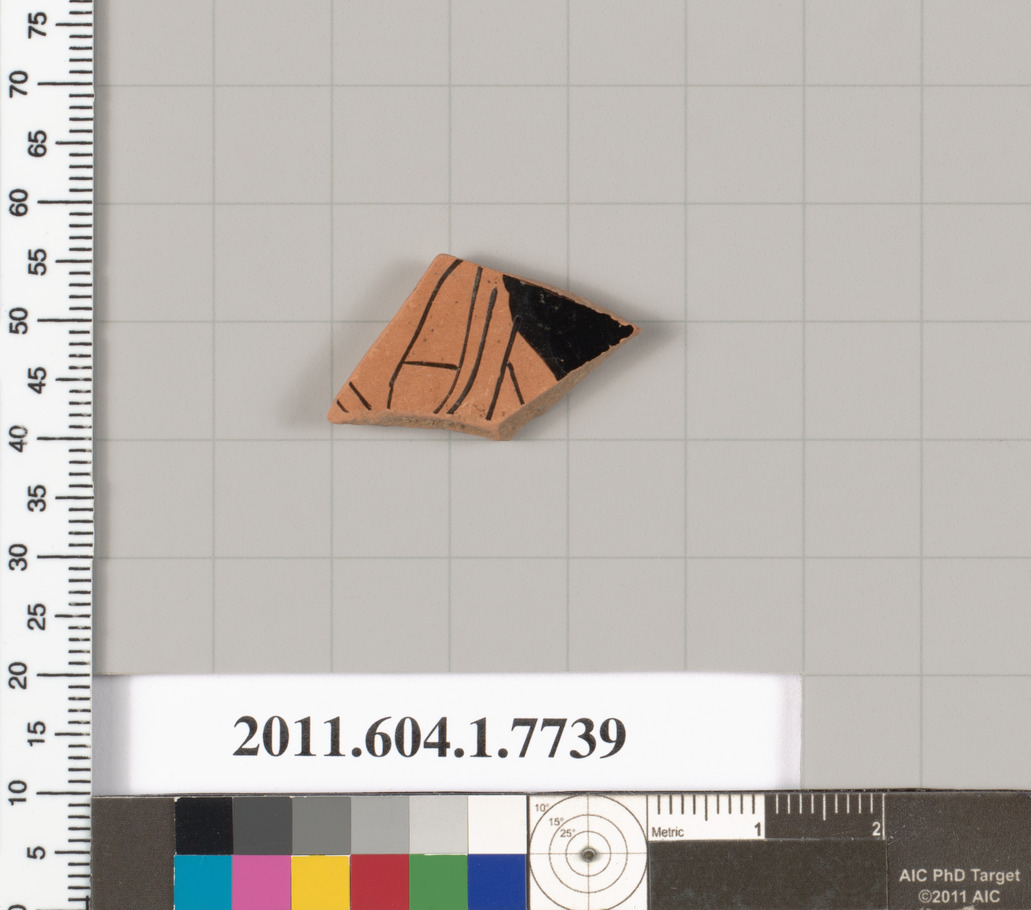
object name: kylix fragment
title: Terracotta fragment of a kylix (drinking cup)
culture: greek, attic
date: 460-450 BCE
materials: terracotta